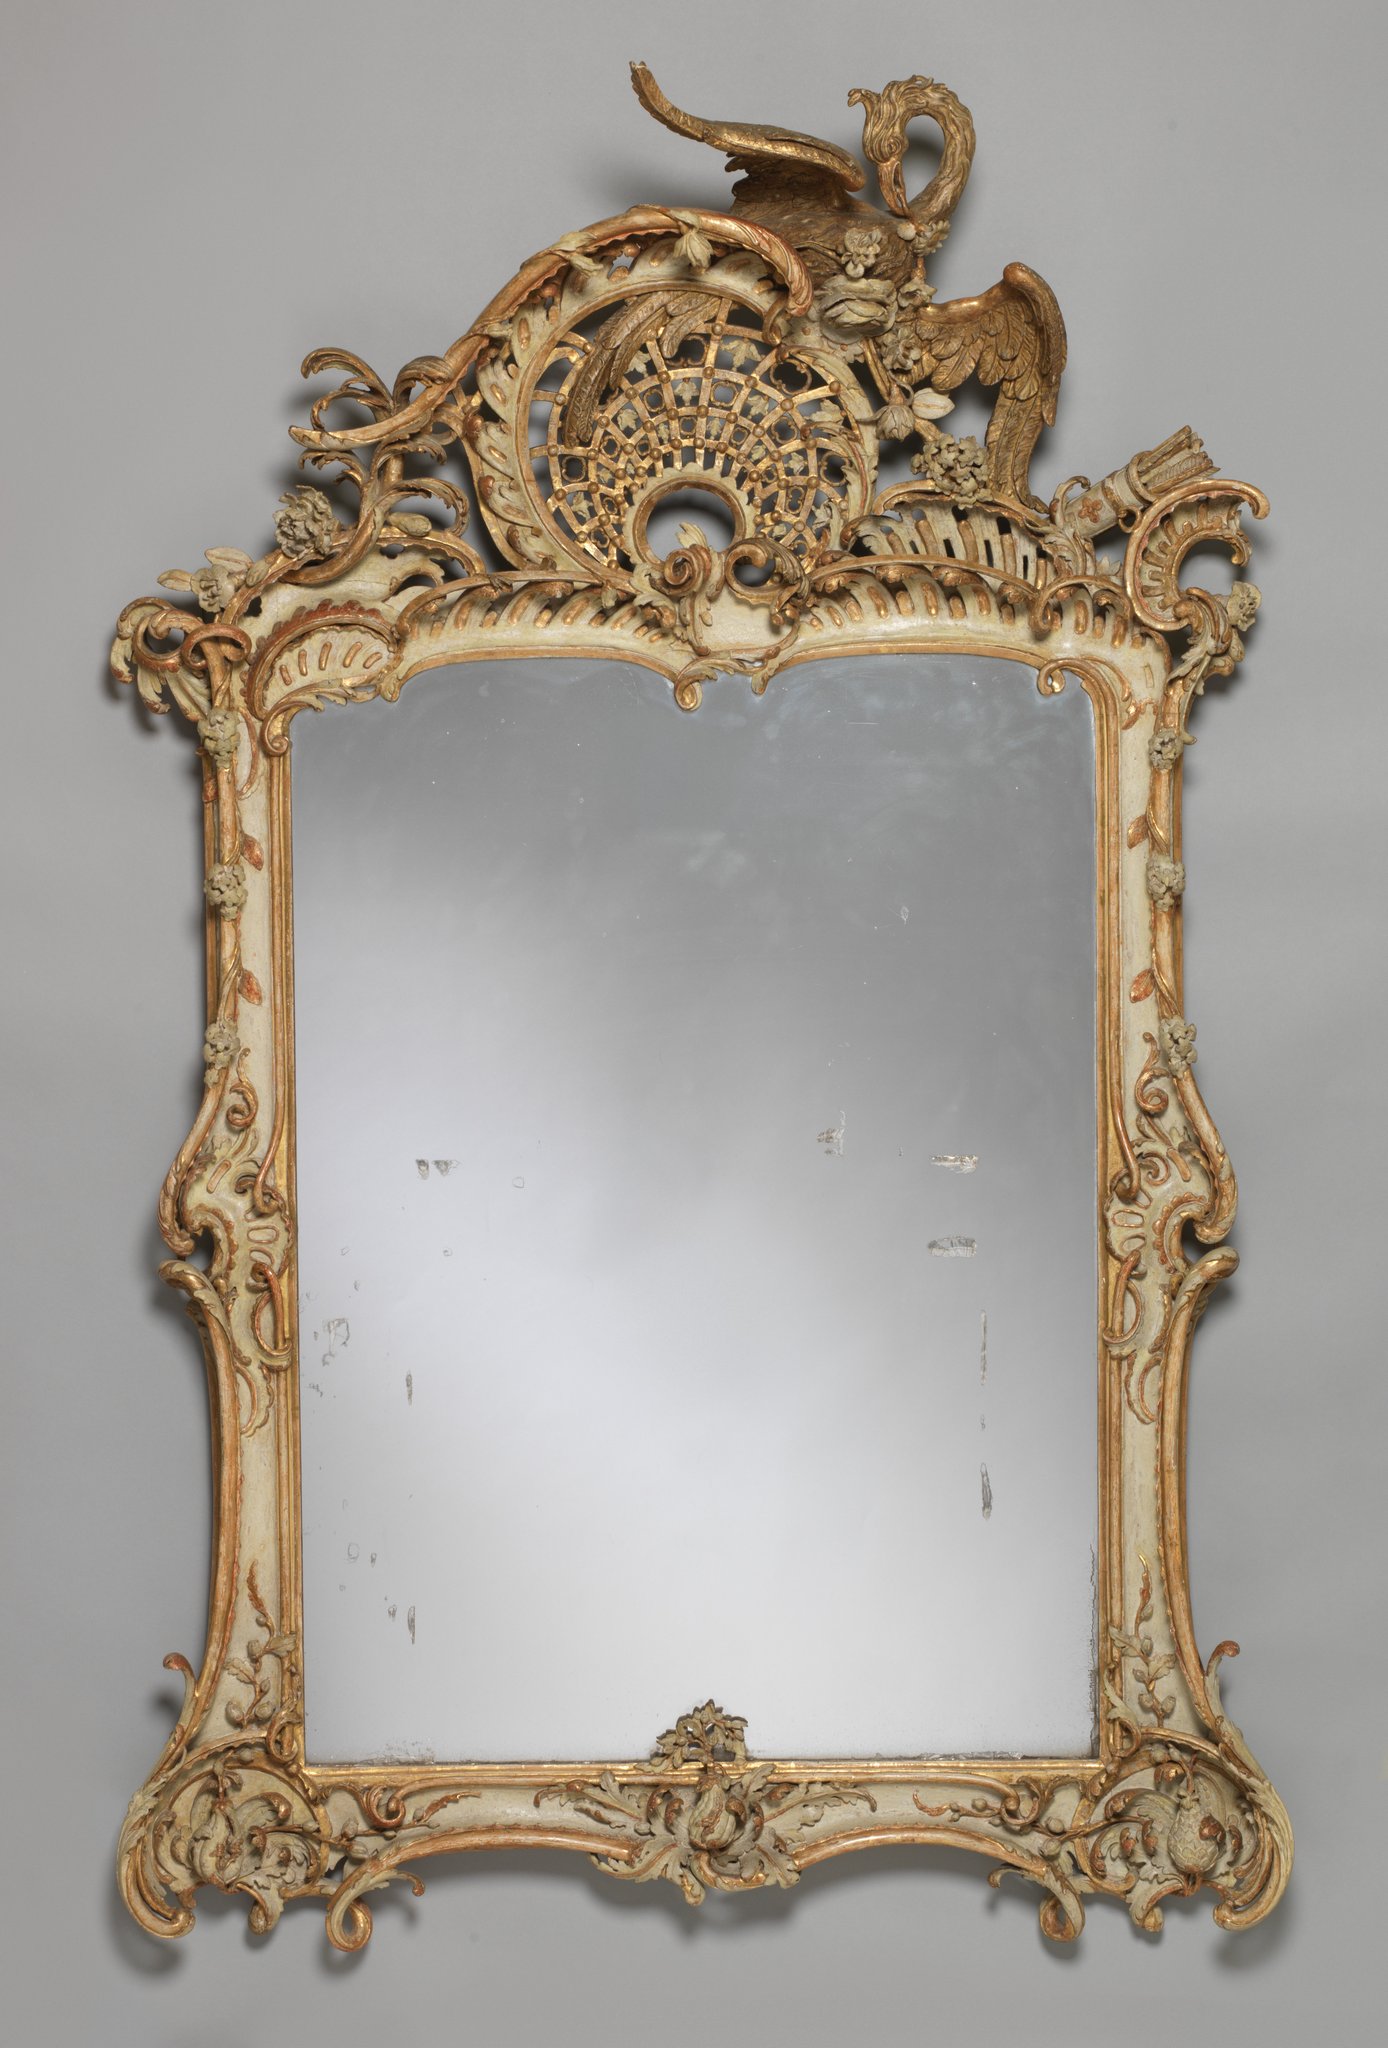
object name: wall mirror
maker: johann michael hoppenhaupt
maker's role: maker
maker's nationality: german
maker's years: 1709-1769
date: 1755-1760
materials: glass, wood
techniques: gilding, painting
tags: birds